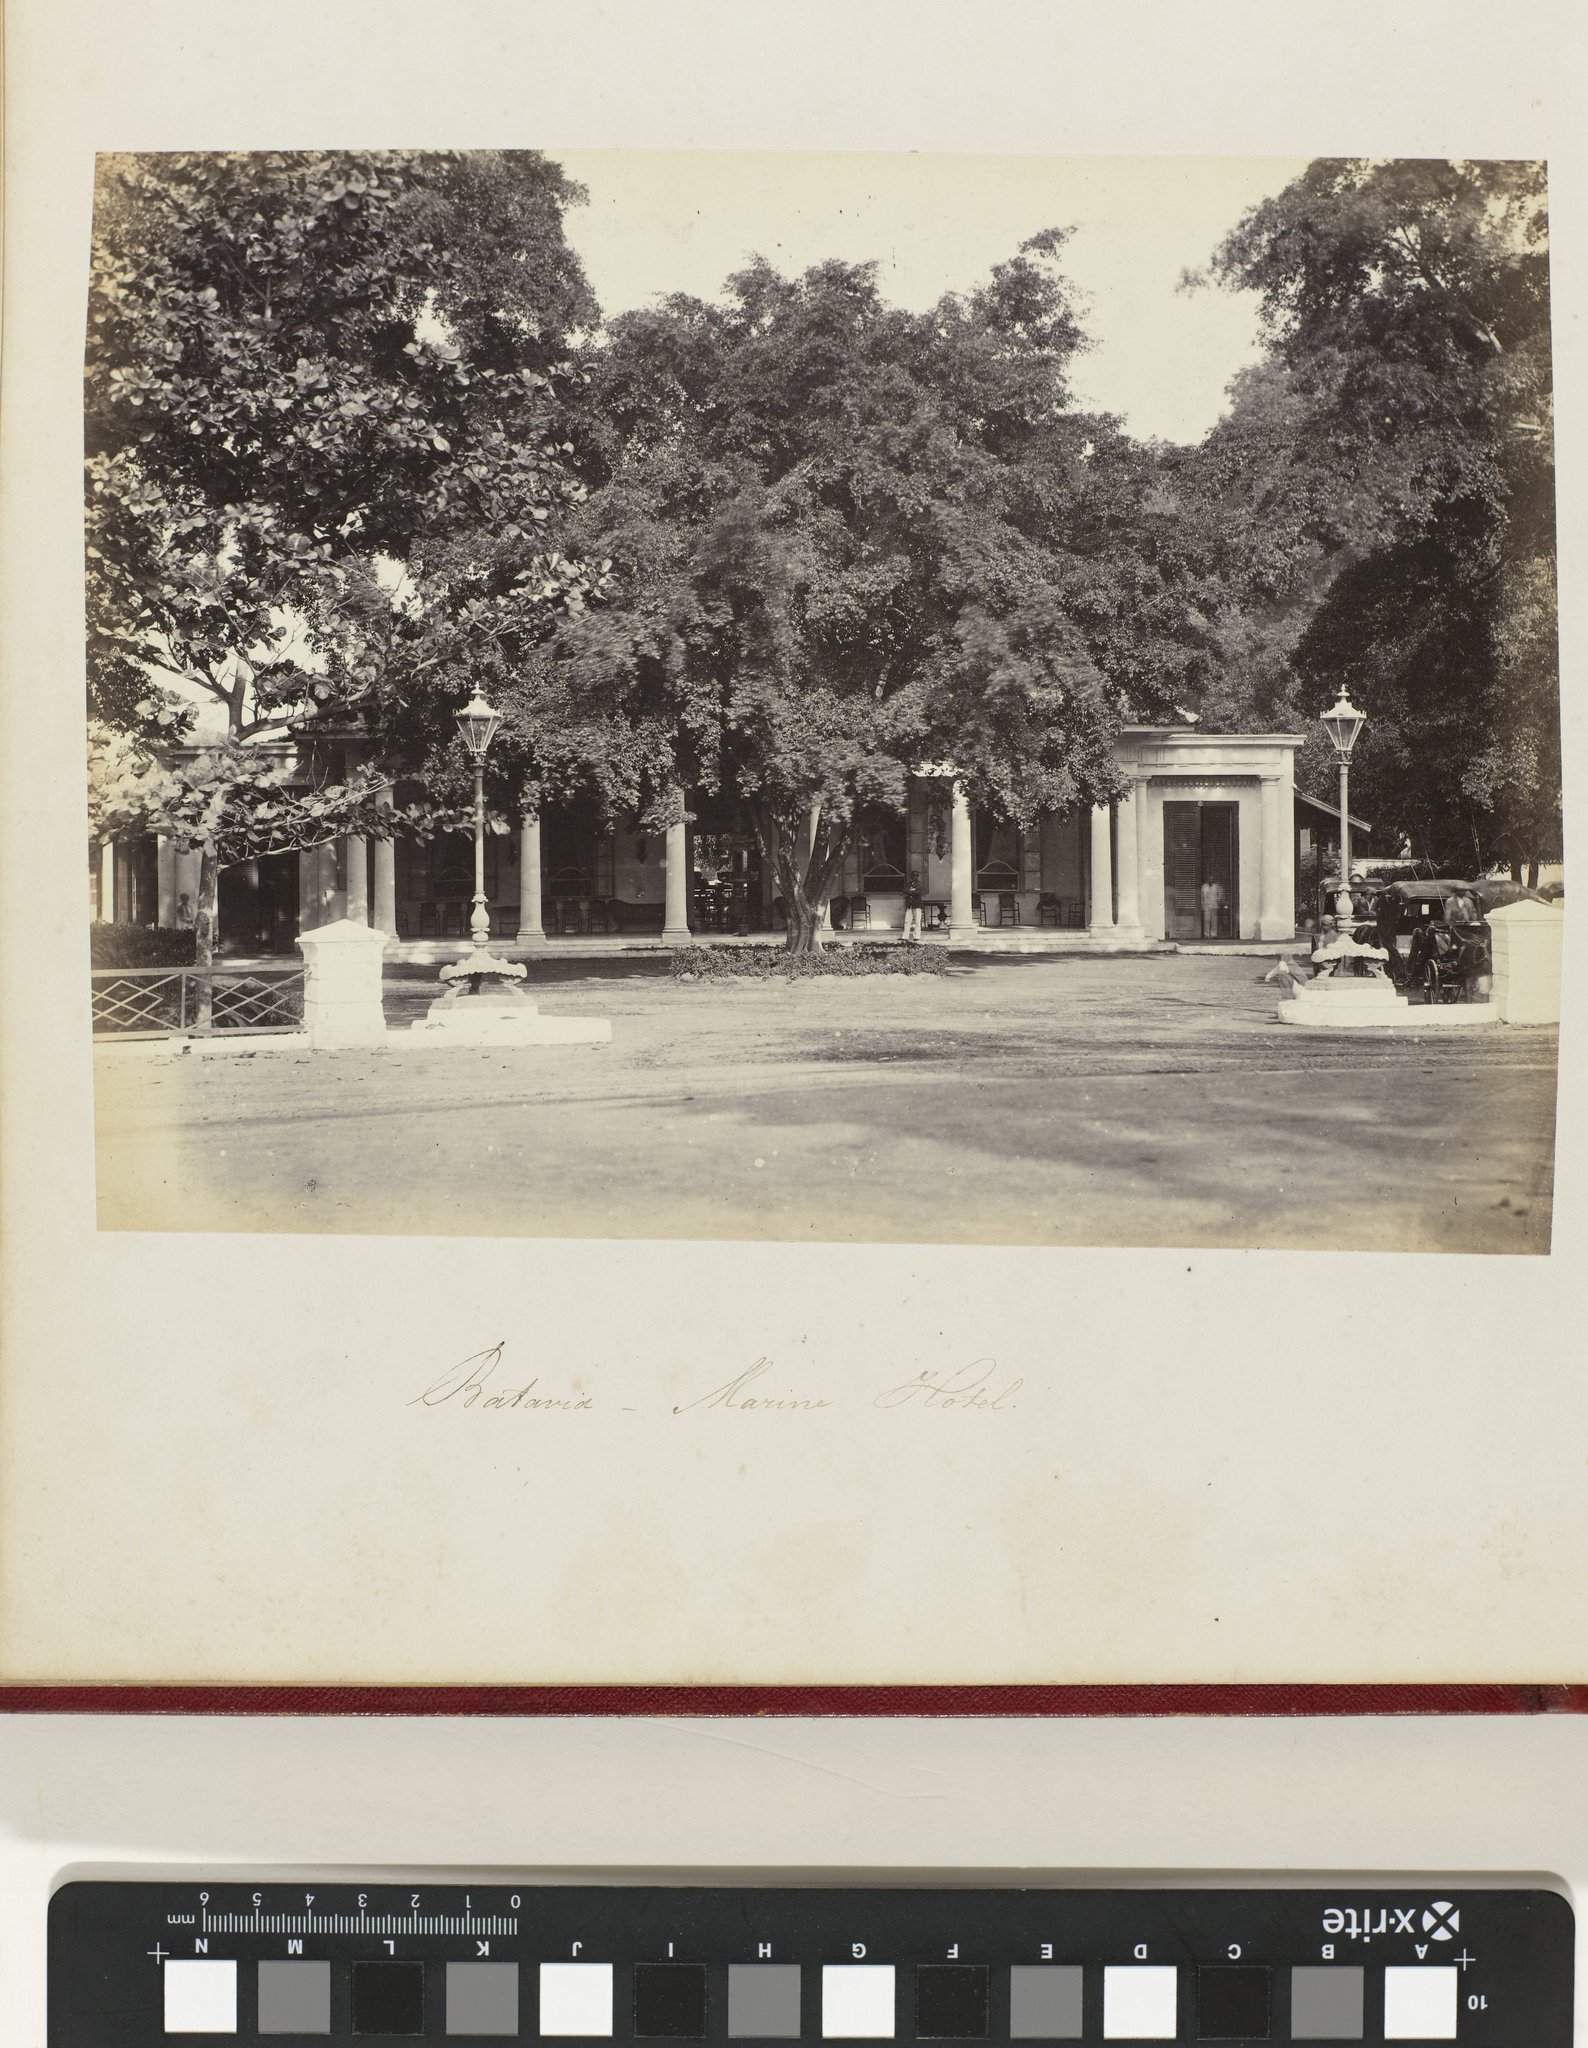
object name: photograph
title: Batavia - Marine Hotel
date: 1863-1866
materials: photographic support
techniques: albumen print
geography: batavia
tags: hotel, hostelry, inn, batavia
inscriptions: inscription: ‘Batavia - Marine Hotel’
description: Gezicht op het Marine Hotel, halfverscholen achter bomen, gelegen aan het Molenvliet in Batavia. Onderdeel van het rode fotoalbum met foto's van Java, uit het bezit van apotheker Specht-Grijp, die in 1865 vanuit Batavia naar Nederland terugkeerde.